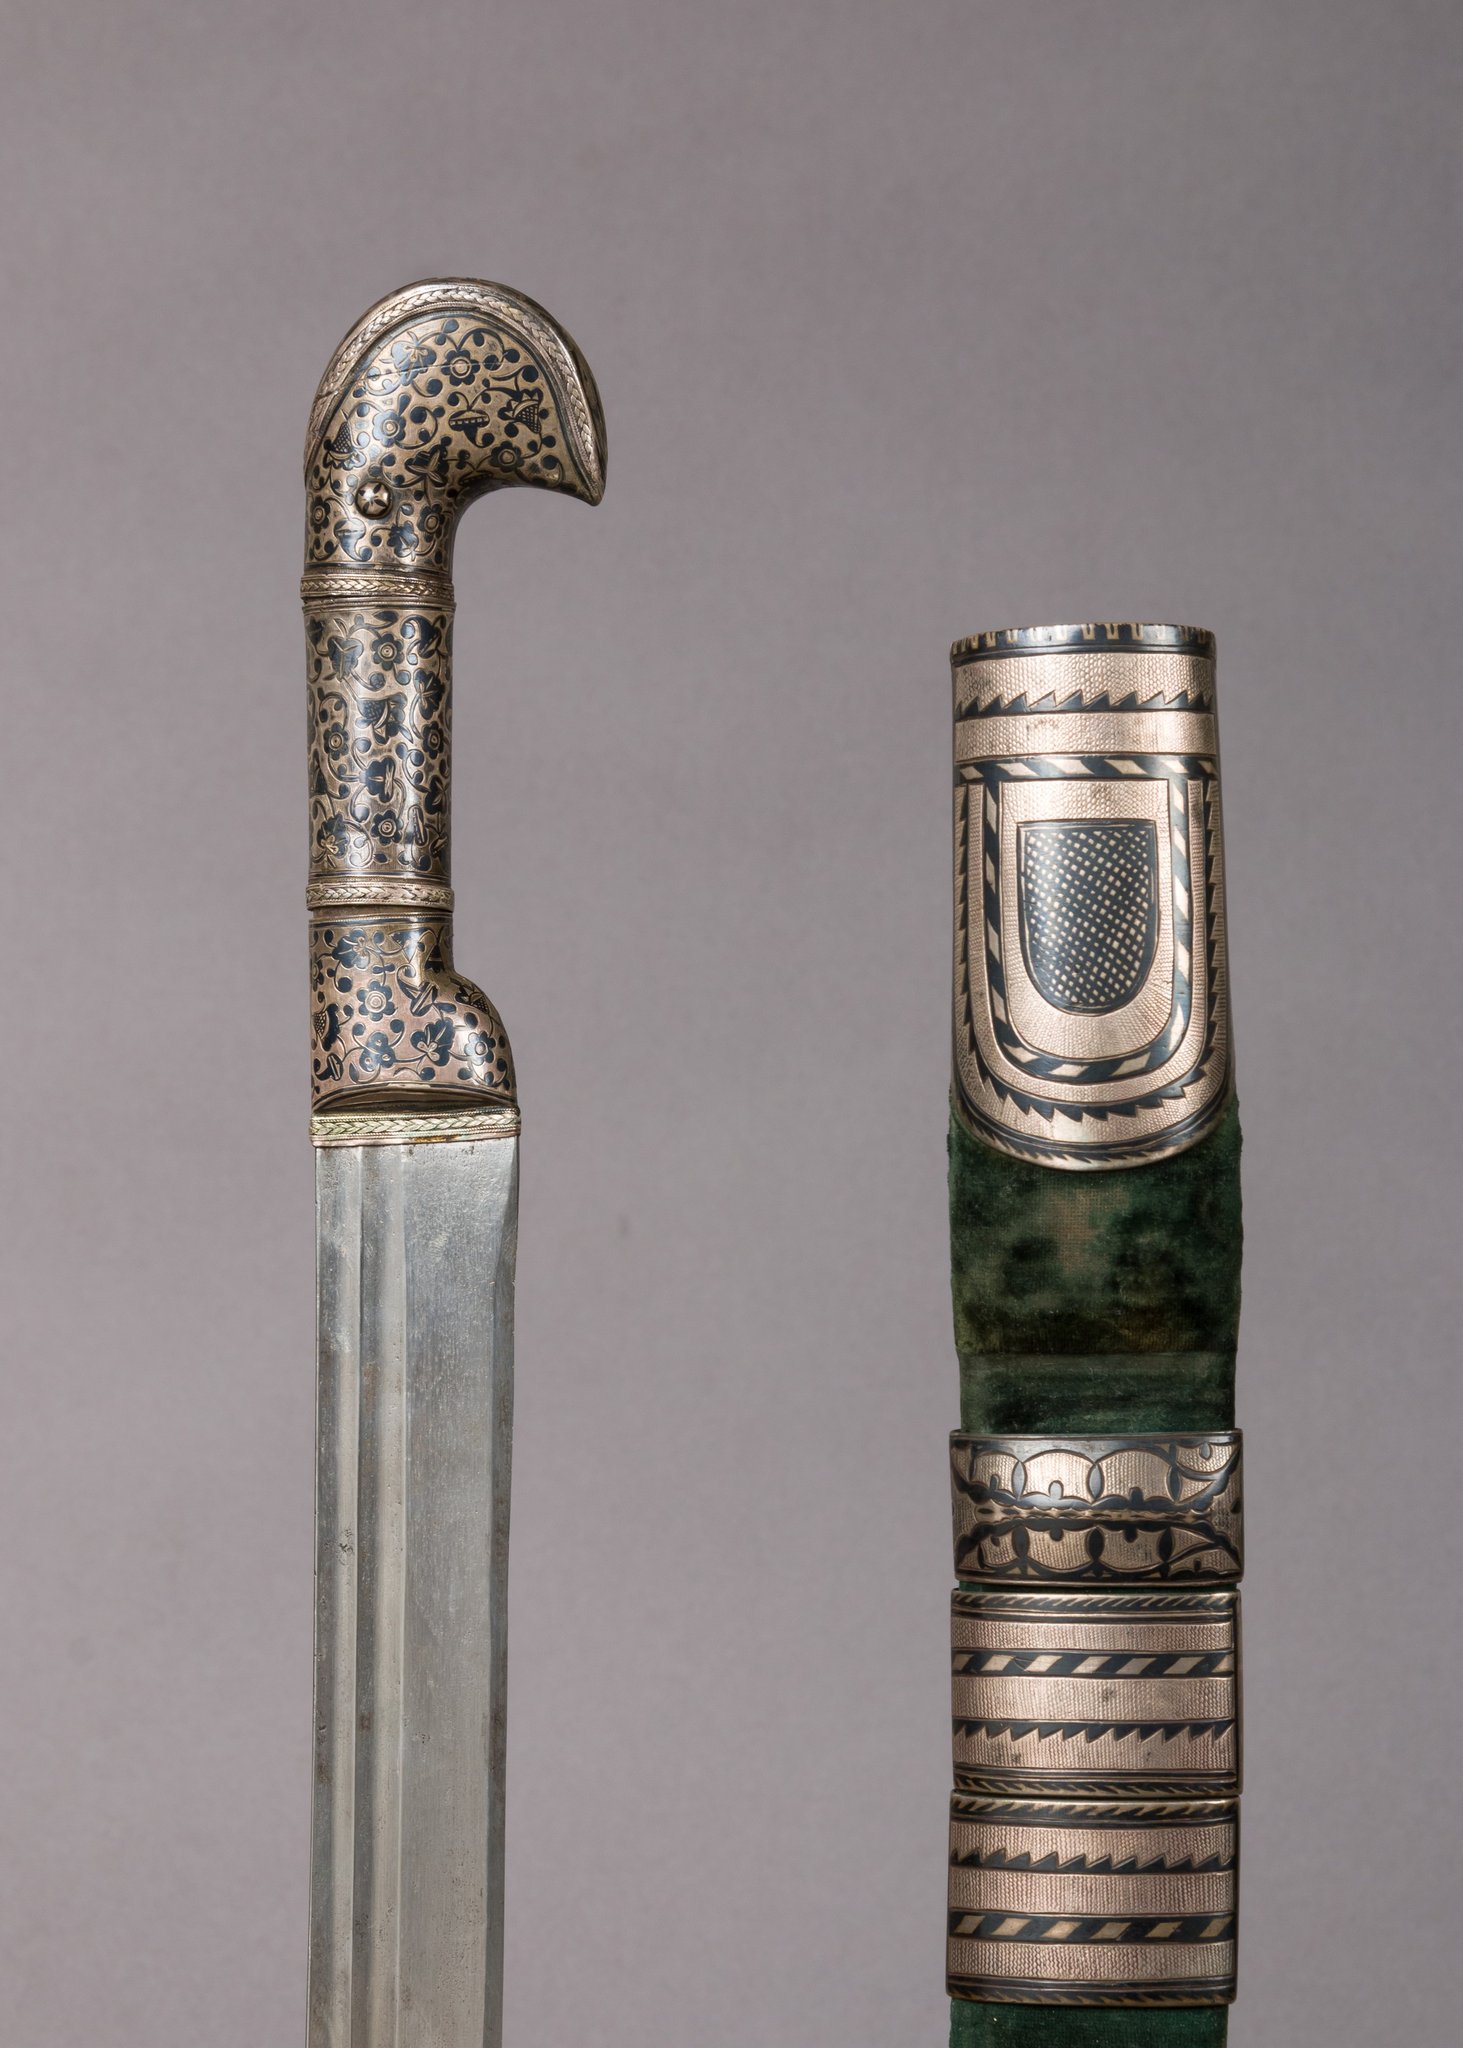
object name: sword with scabbard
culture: caucasian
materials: niello, silver, steel, textile, wood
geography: caucasus